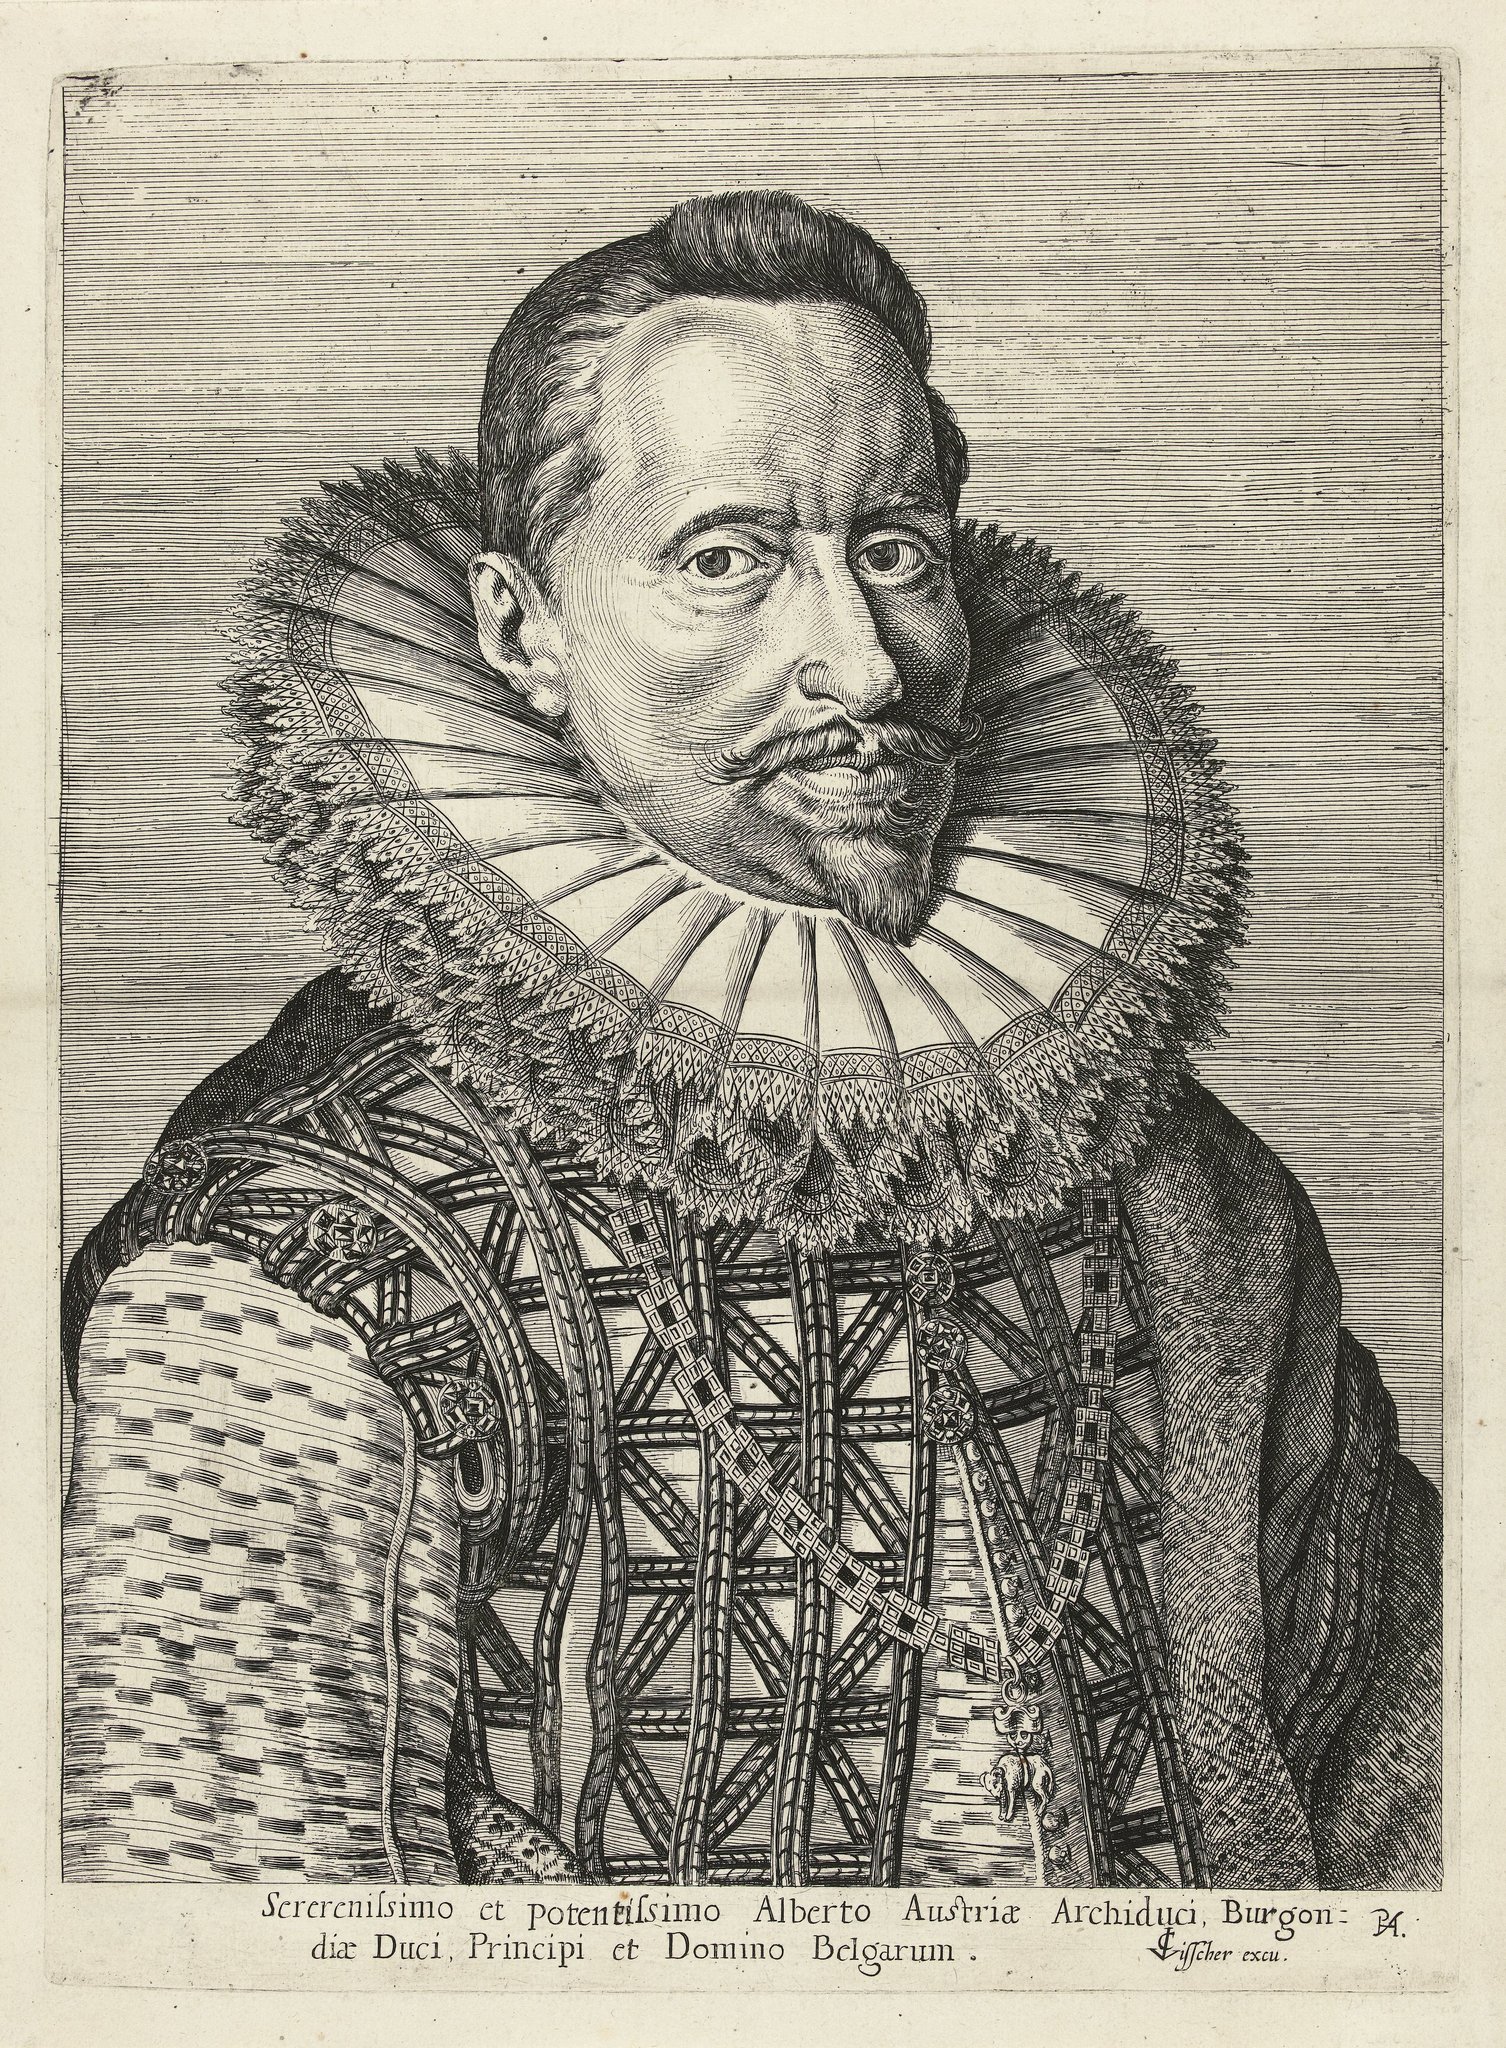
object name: print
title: Portret van Albrecht van Oostenrijk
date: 1612-1650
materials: paper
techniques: engraving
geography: leeuwarden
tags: brussels, albrecht aartshertog van oostenrijk, knighthood order of the golden fleece - insignia of a knighthood order, e.g.: badge, chain (with name of order)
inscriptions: collector's mark: Lugt 2228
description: Busteportret van Albrecht, aartshertog van Oostenrijk, gouverneur der Nederlanden, afgebeeld met molenkraag en ketting met insigne van de Orde van het Gulden Vlies. Onder de voorstelling twee regels Latijn.